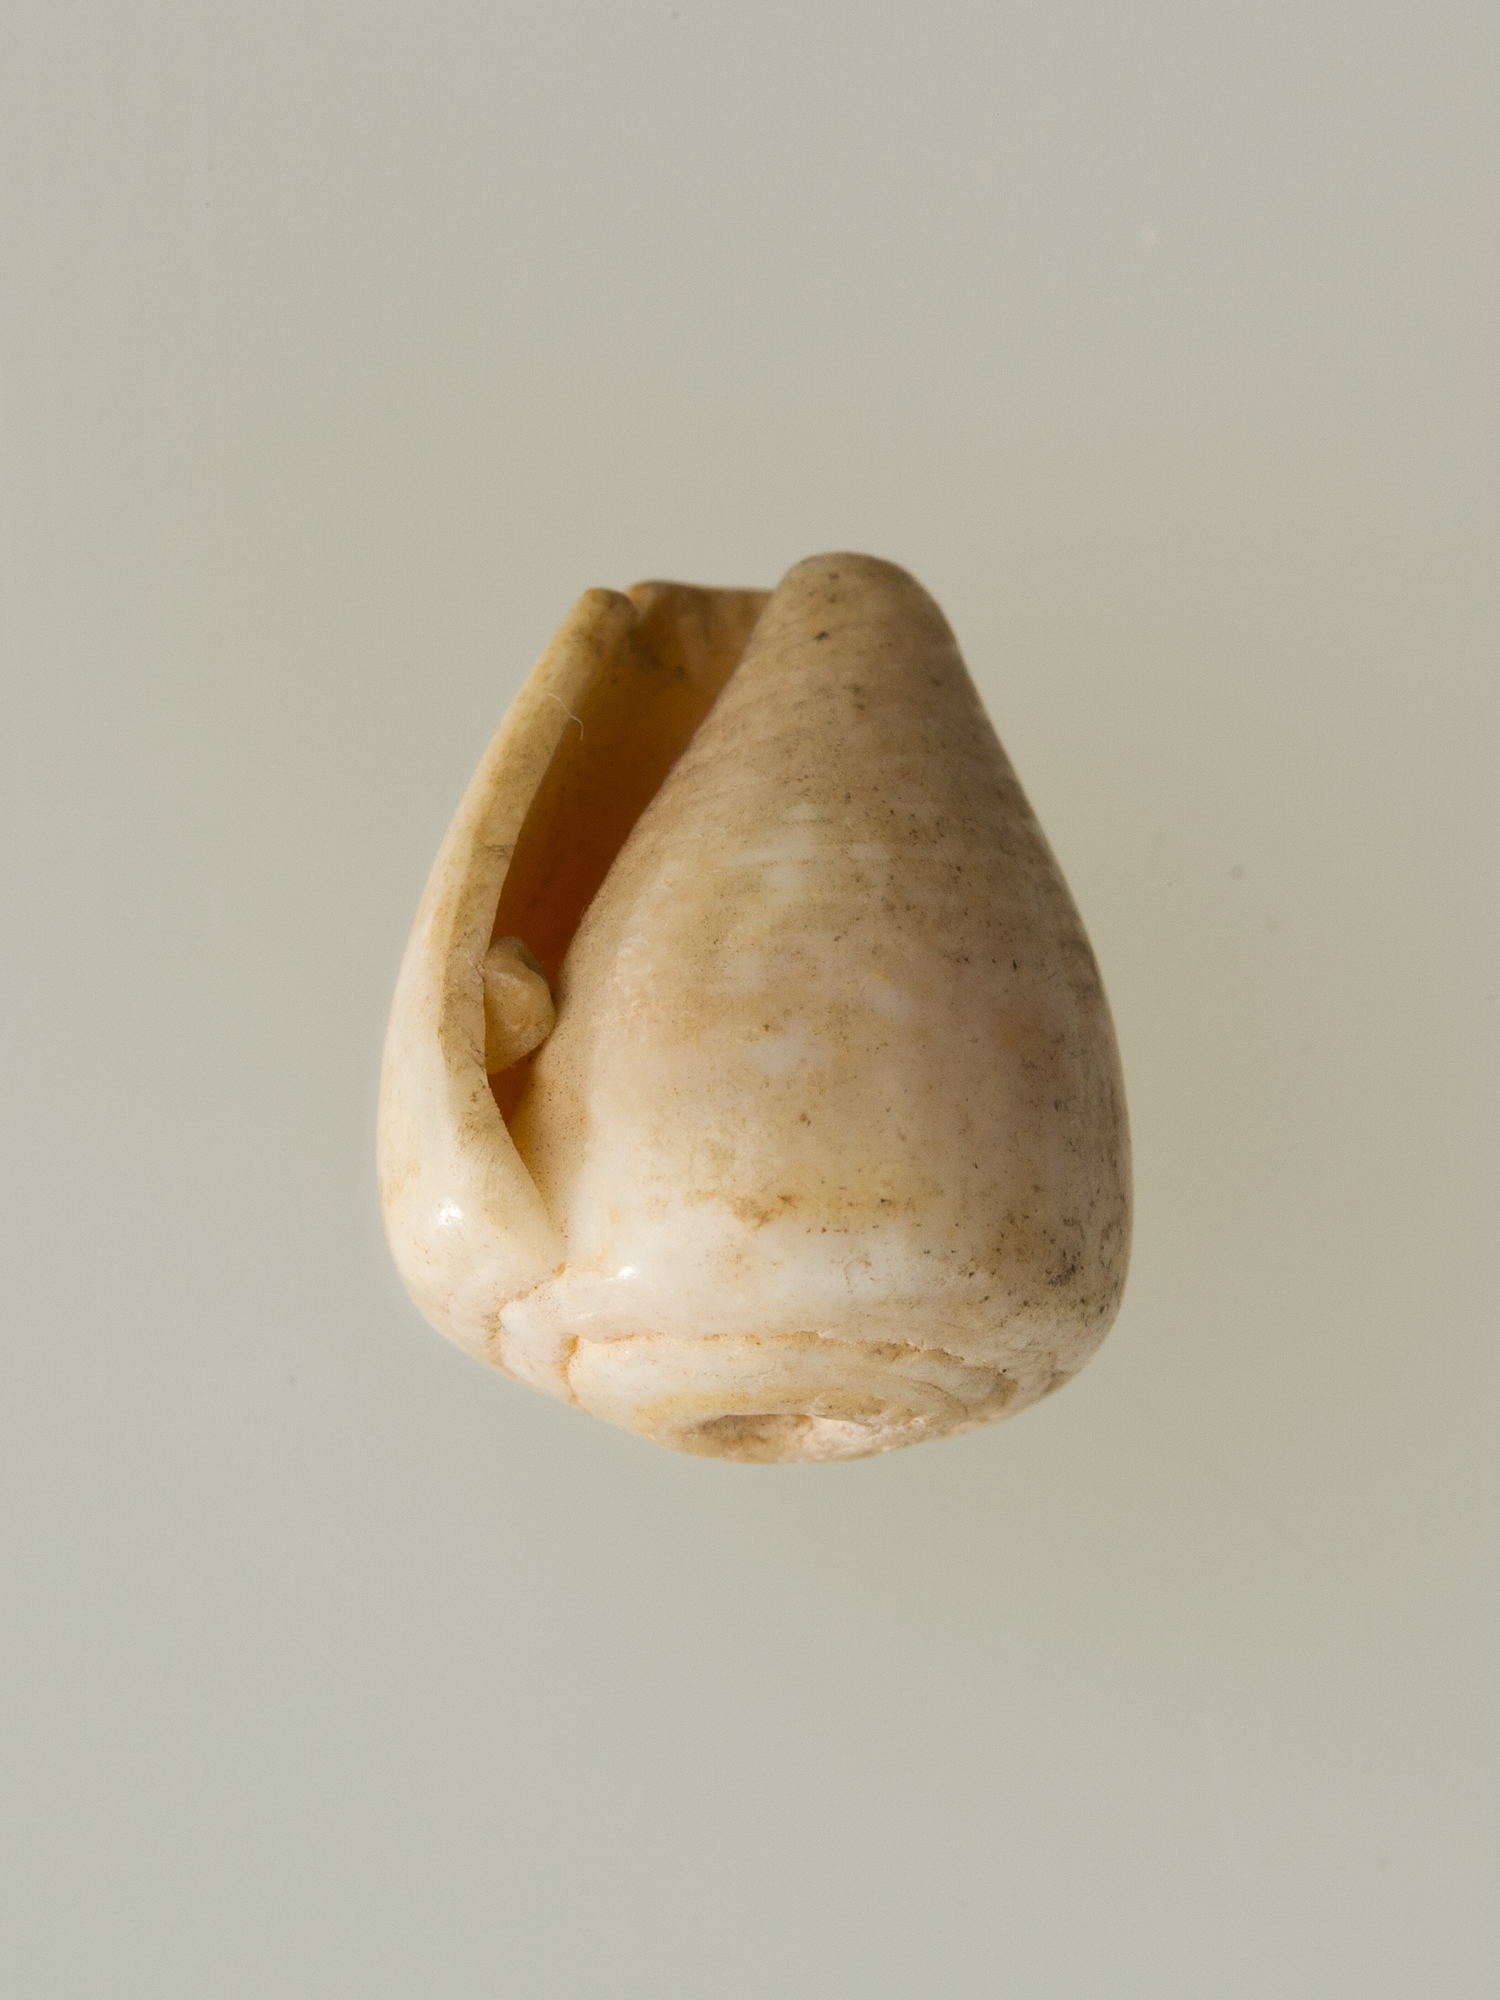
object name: pendant, shell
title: Shell pendant or bead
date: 3850-2960 BCE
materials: shell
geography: egypt